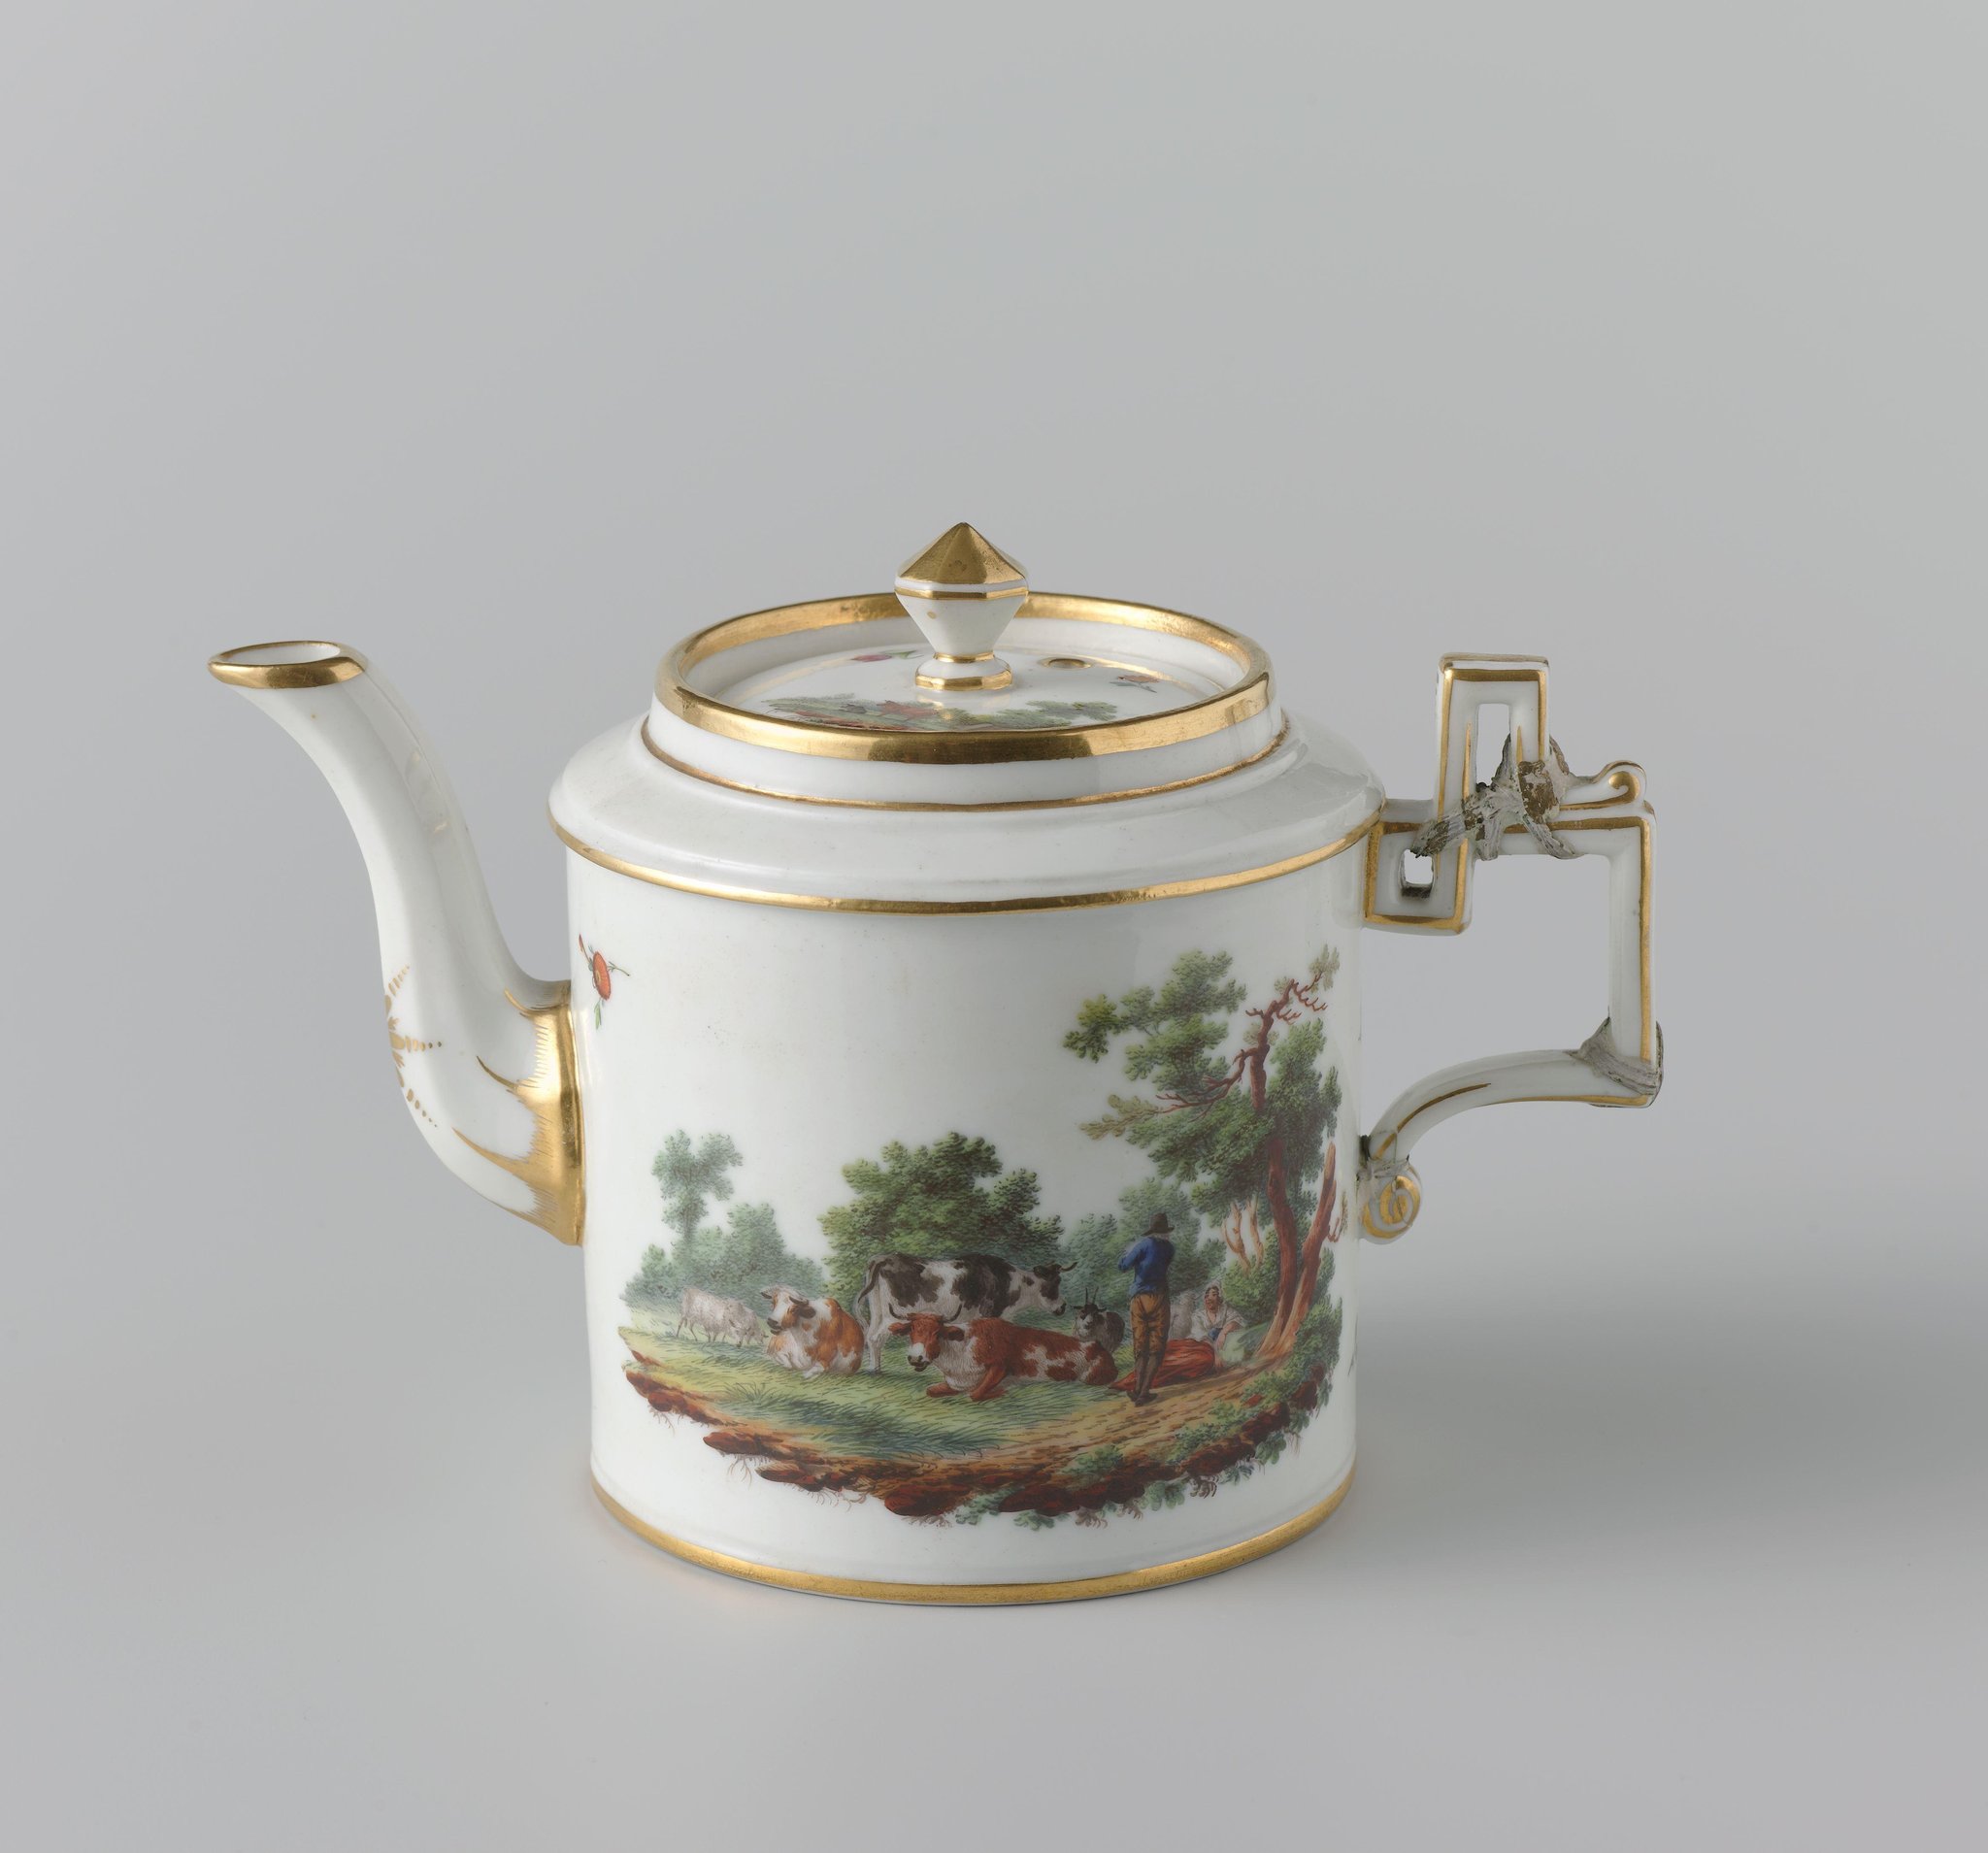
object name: tea service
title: Theepot, beschilderd met een landschap met vee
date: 1809-1814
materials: porcelain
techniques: painted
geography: nieuwer-amstel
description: Theepot beschilderd met landschap met vee. Gemerkt: Amstel in blauw.